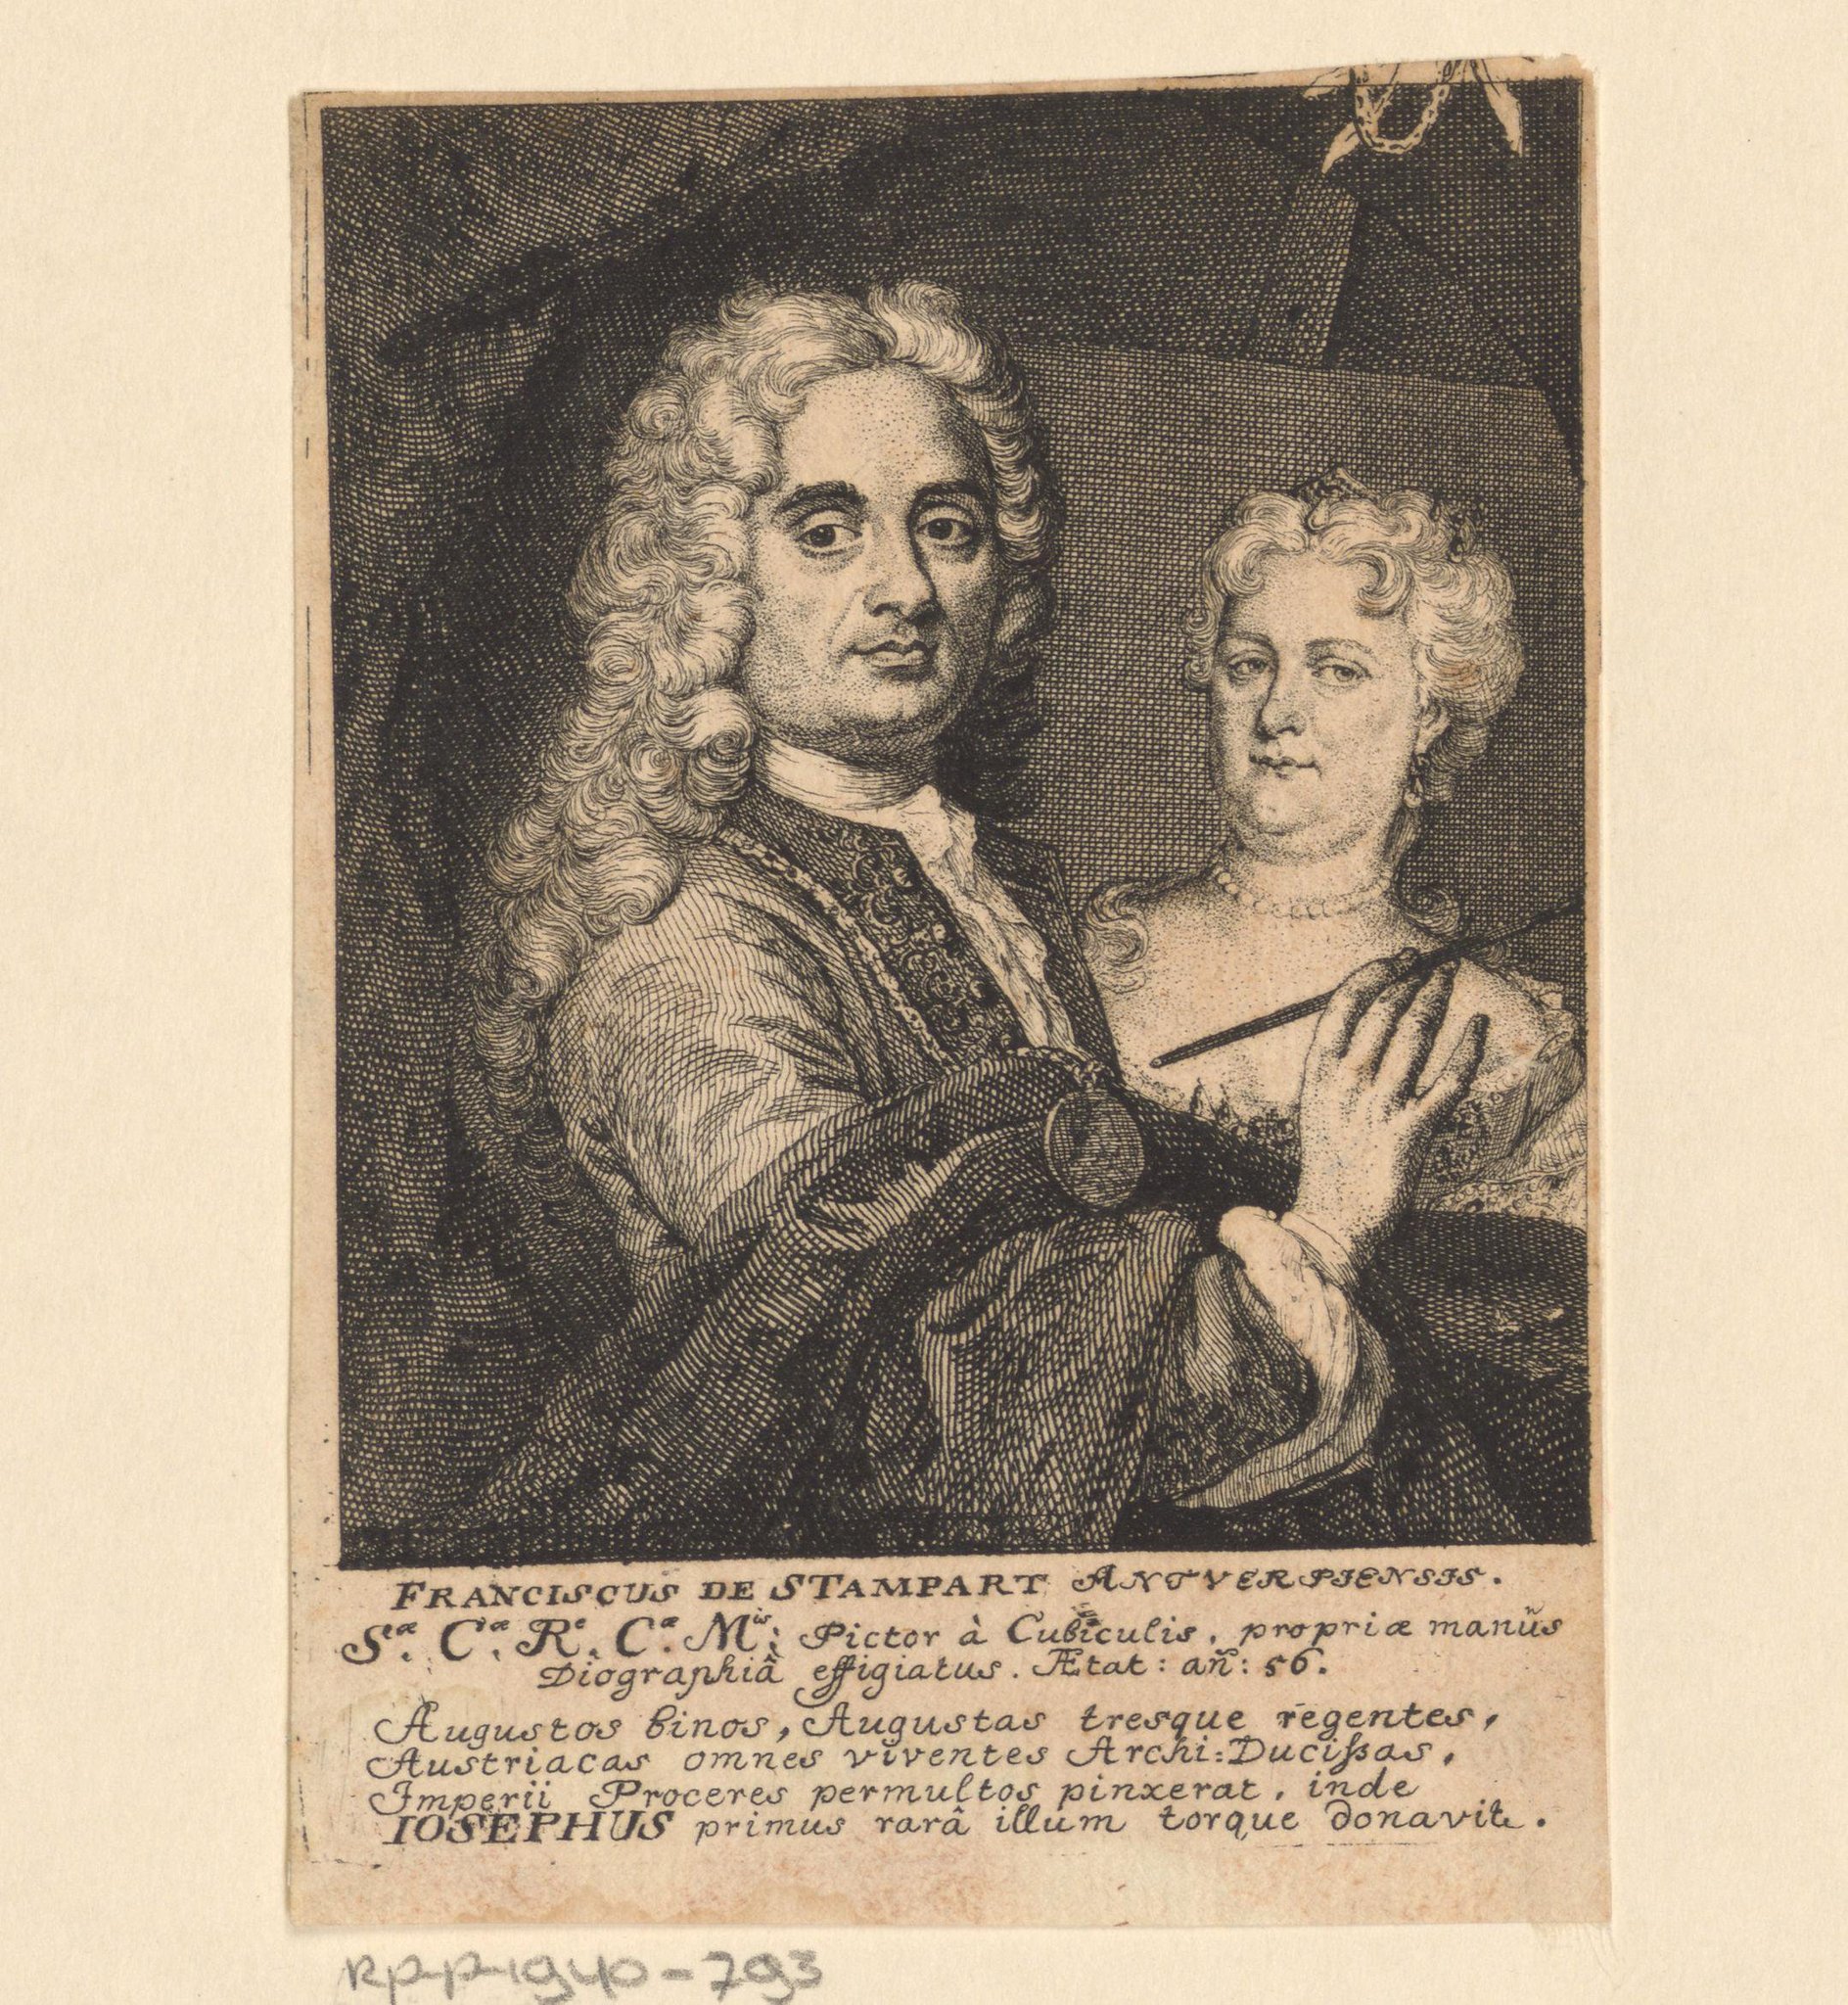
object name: print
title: Portret van Frans van Stampart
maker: Anonymous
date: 1735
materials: paper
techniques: etching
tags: antwerp, vienna, frans van stampart, historical persons, portrait, self-portrait of artist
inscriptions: collector's mark: Lugt 2228, collector's mark: Lugt 2760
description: Prent waarschijnlijk uit: Stampart, Frans van. Prodromus, seu Praeambulare lumen reserati portentosae magnificentiae theatri, quo omnia ad aulam caesaream in Augustissimae suae caesareae (...). Neurenberg: Johann Peter von Ghelen, 1735.